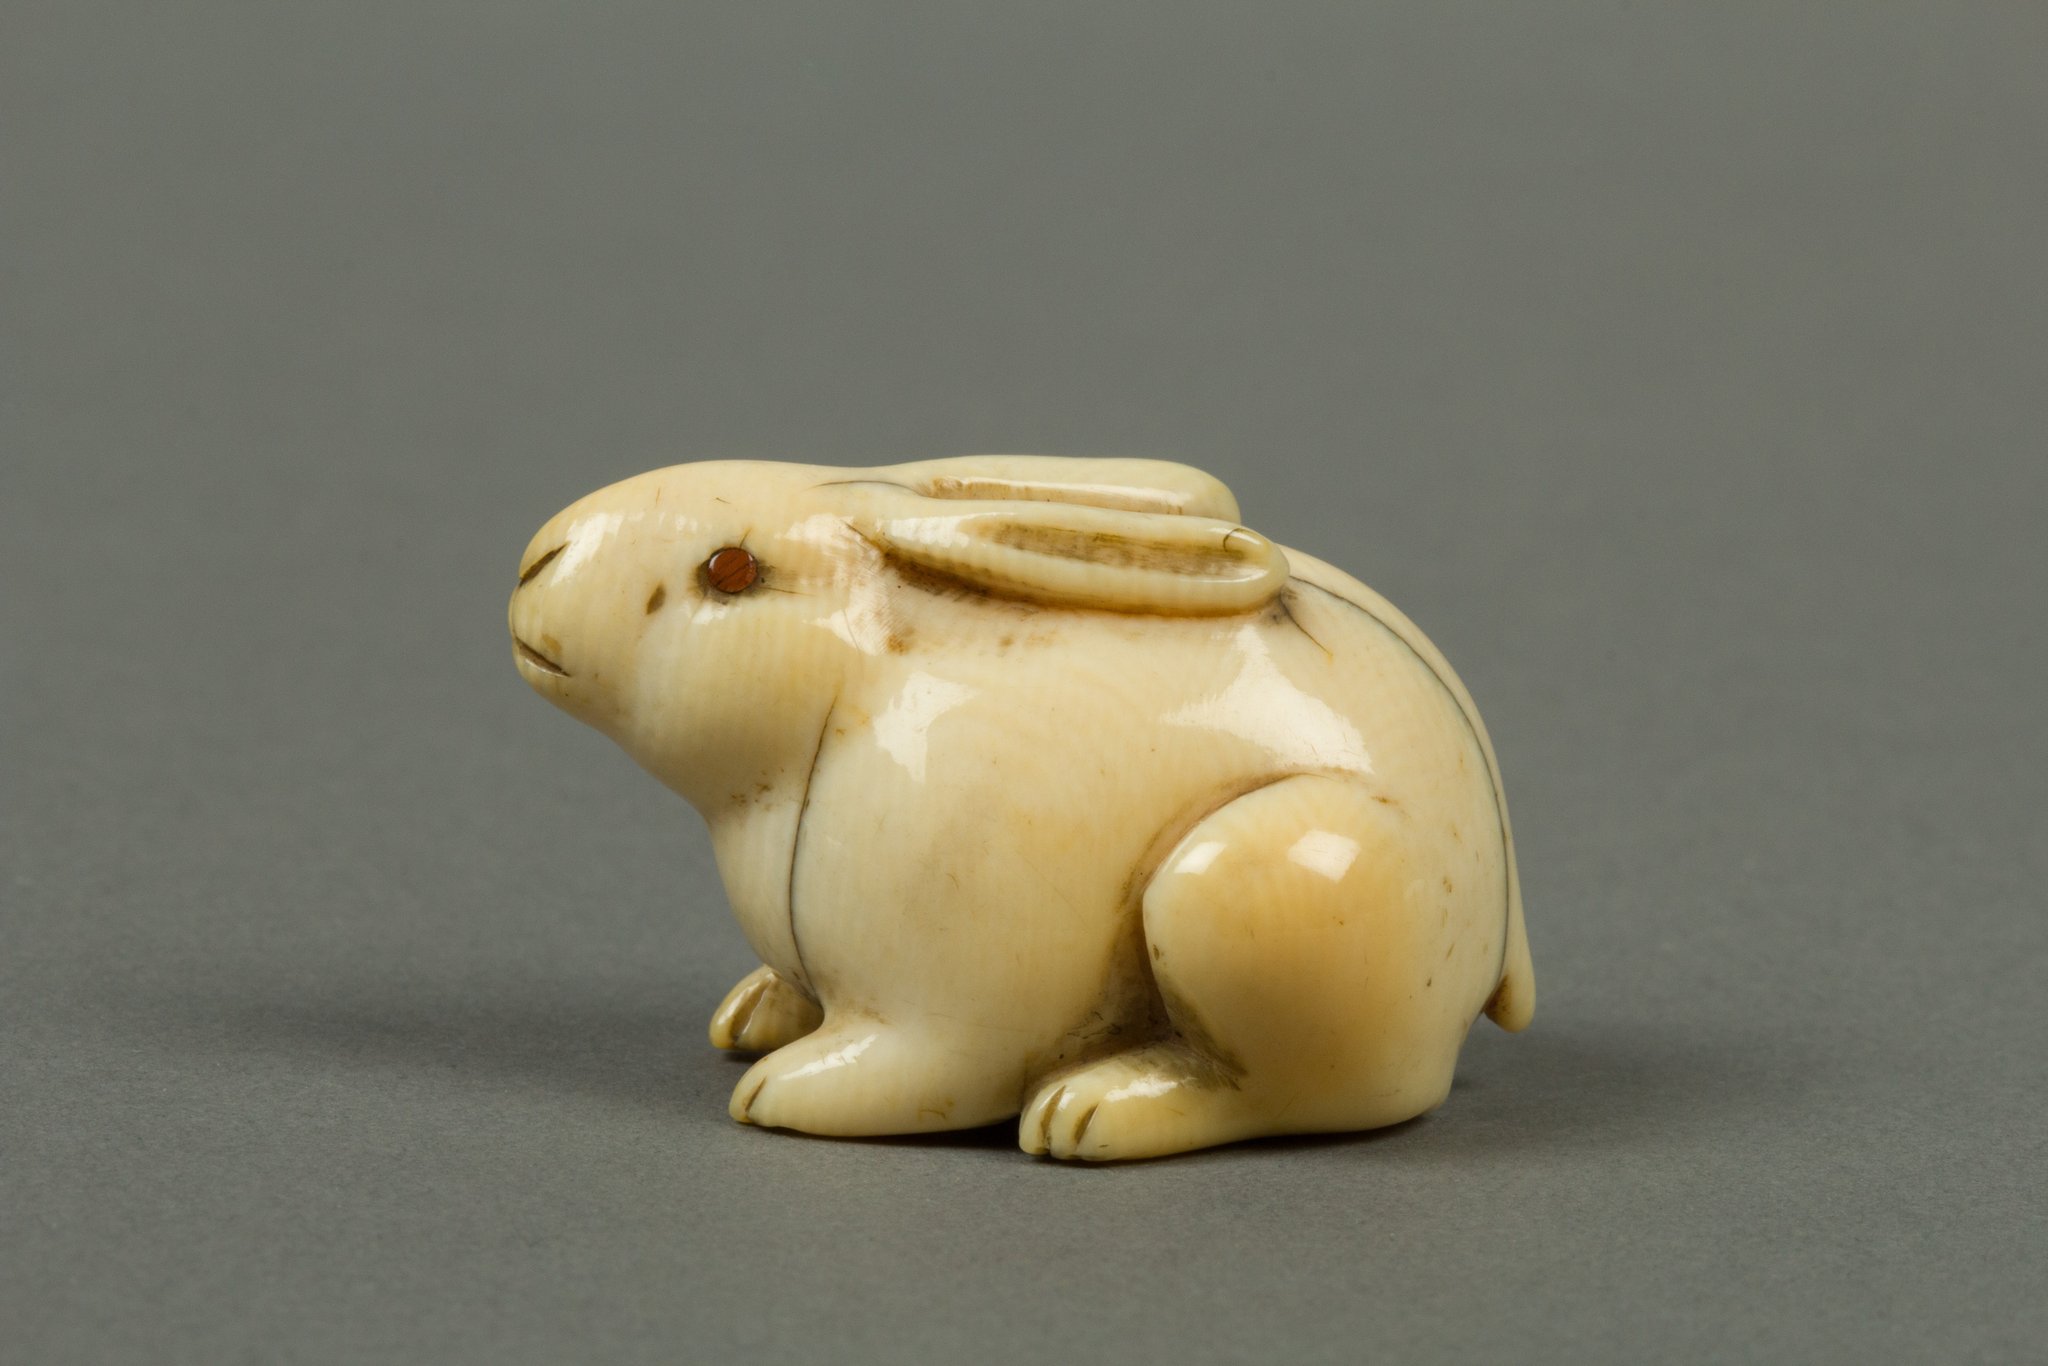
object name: netsuke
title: Netsuke of Rabbit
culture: japanese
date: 1801-1900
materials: ivory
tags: rabbits